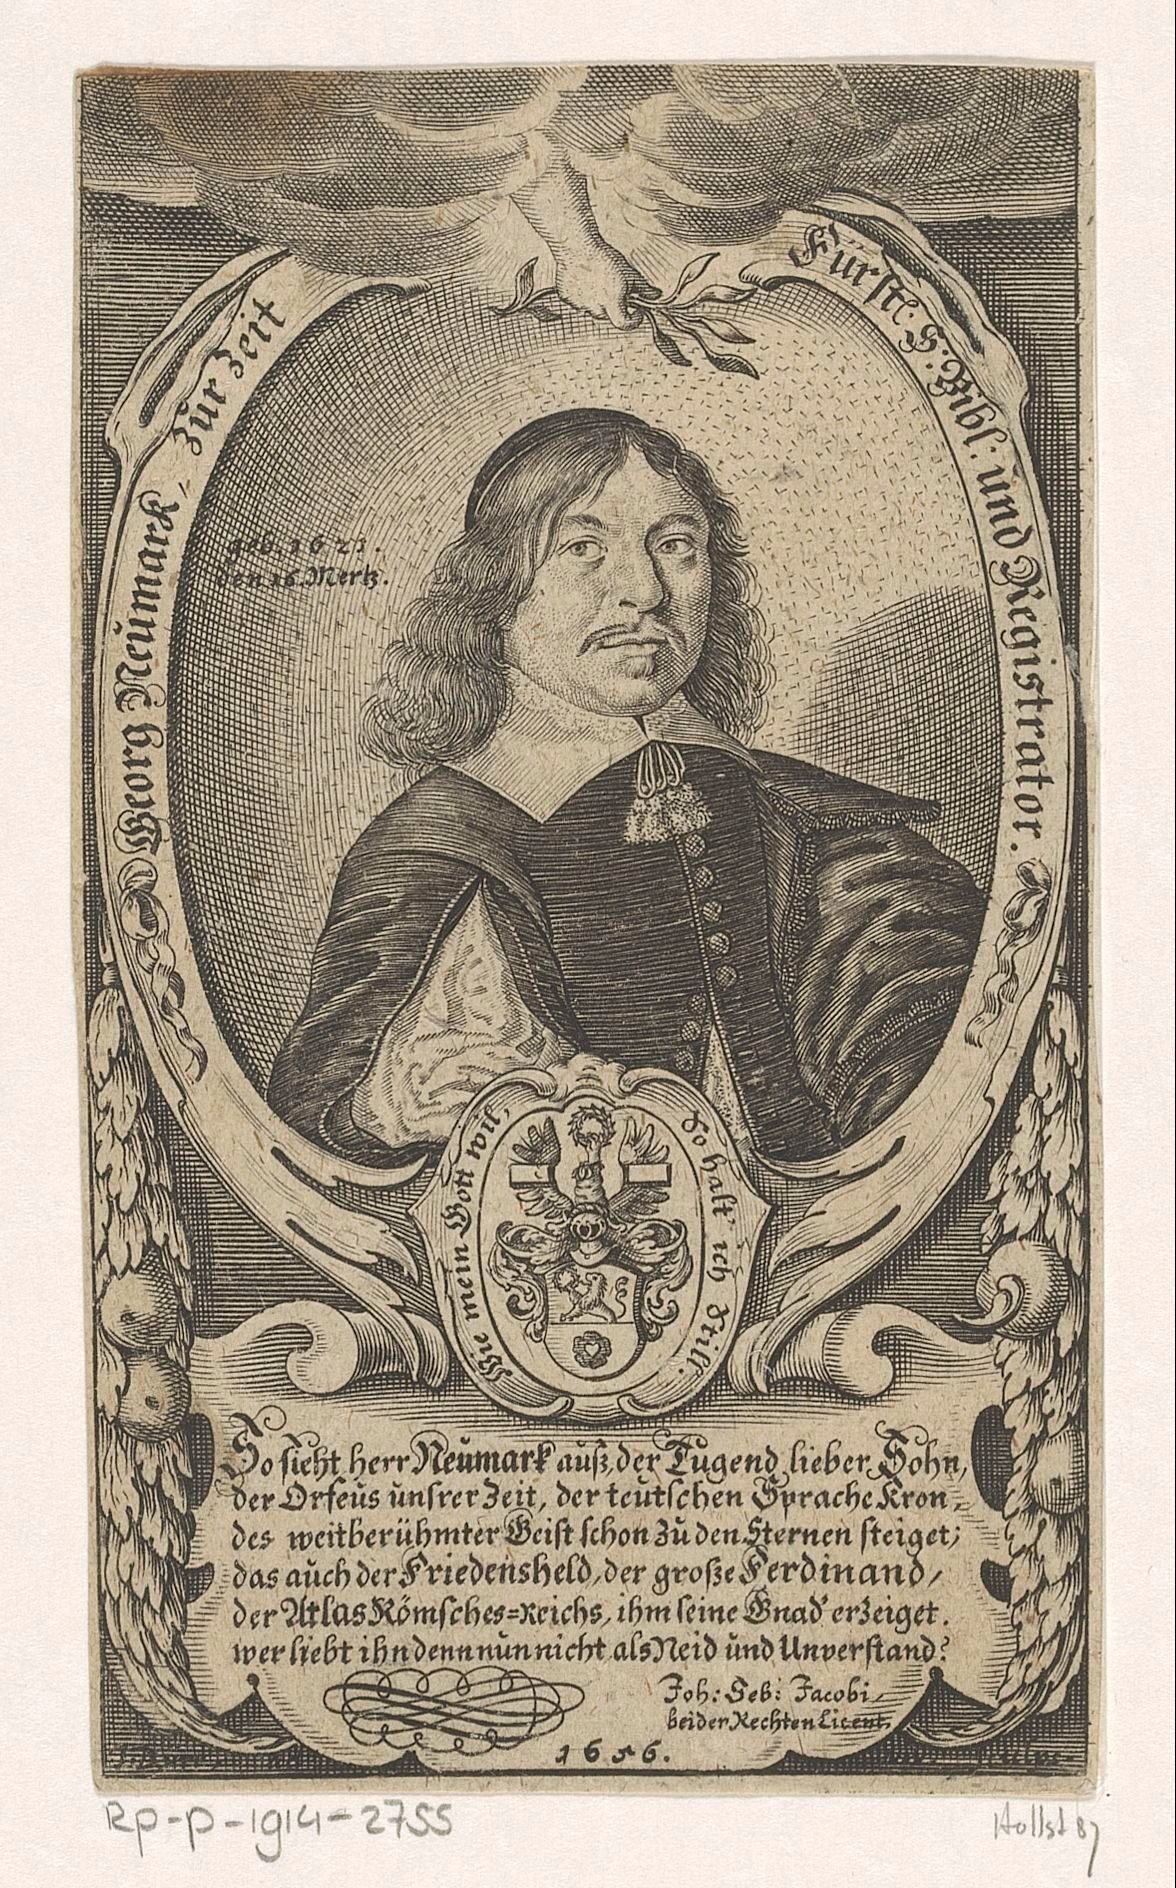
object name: print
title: Portret van Georg Neumark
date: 1656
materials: paper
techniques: engraving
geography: germany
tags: georg neumark, crowning with laurel (+ variant), ornament ~ medallion, historical persons, ornament ~ cartouche, ornament ~ festoon, garland, armorial bearing, heraldry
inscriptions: collector's mark: Lugt 2228